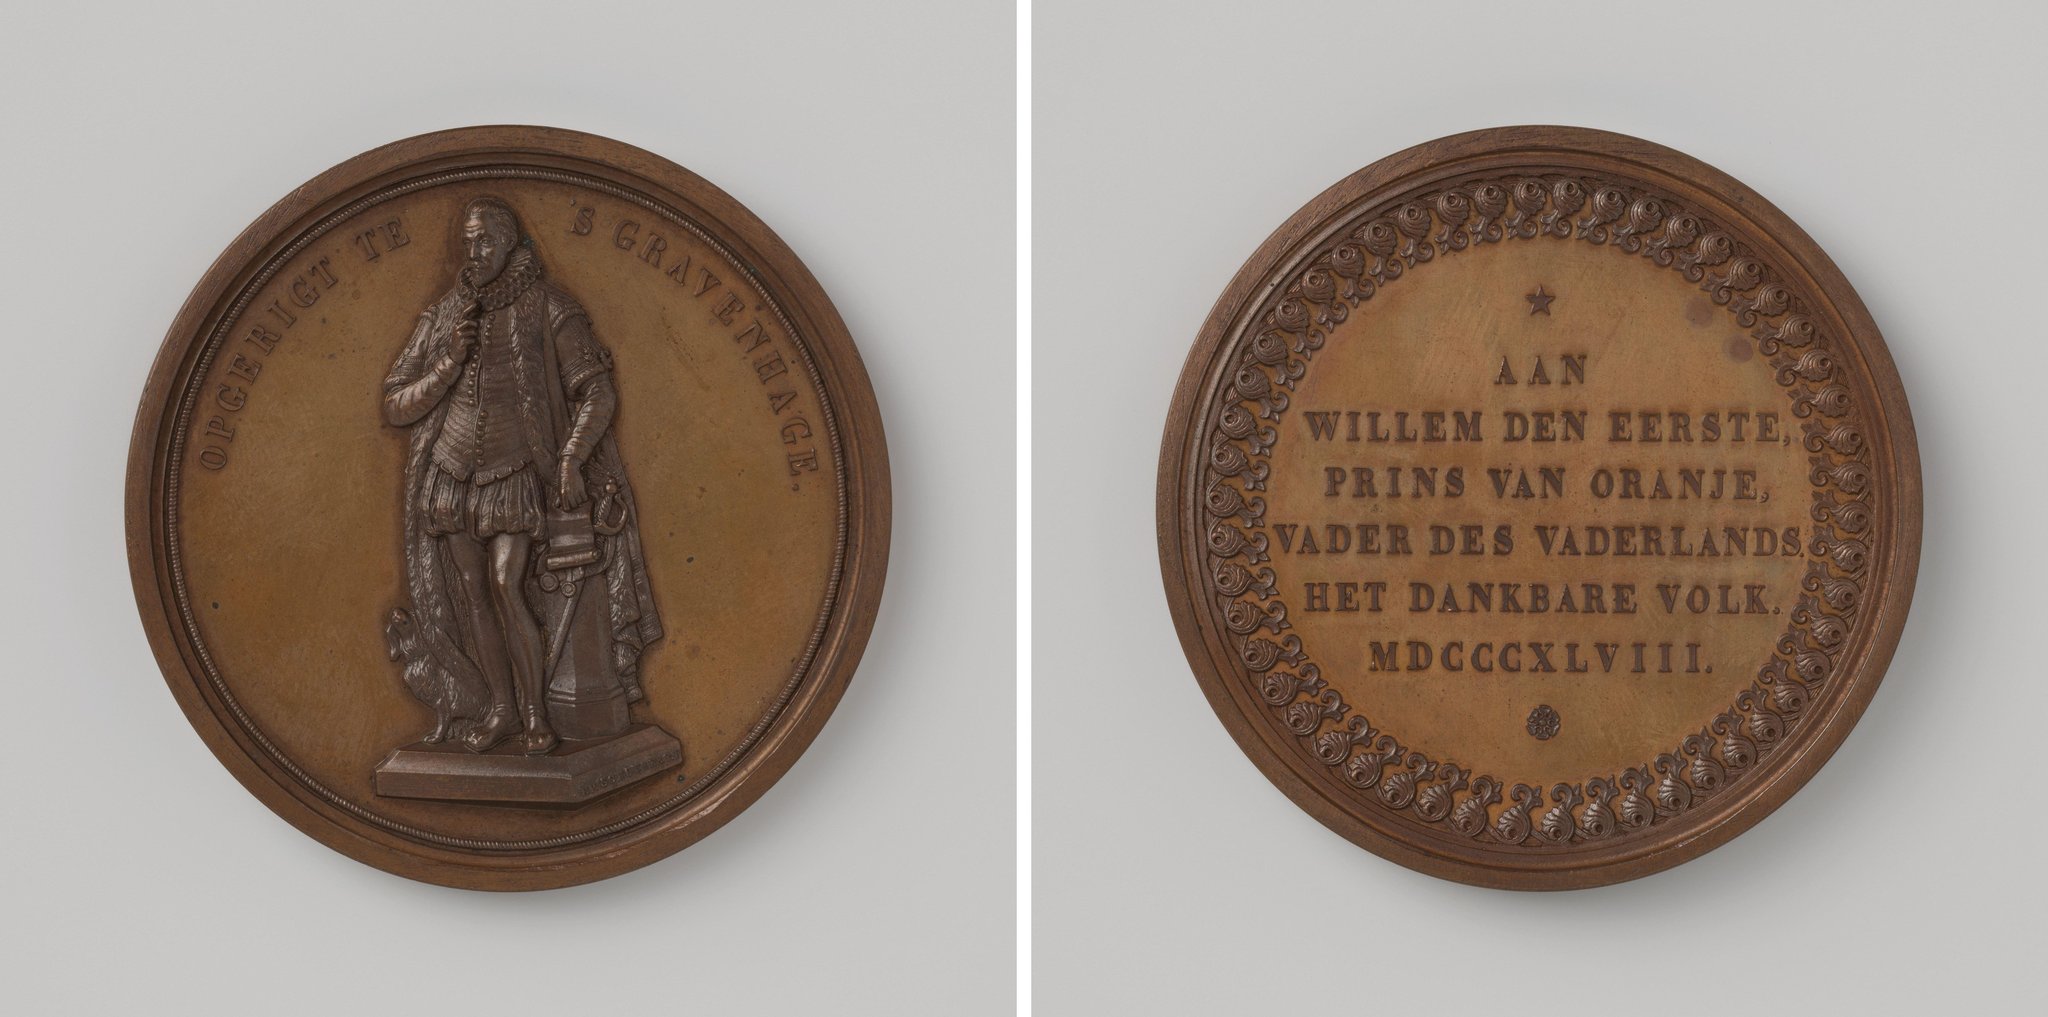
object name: history medal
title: Oprichting van het standbeeld van Willem van Oranje te Den Haag 1848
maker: johannis petrus schouberg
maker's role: die cutter, draughtsman, print maker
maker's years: 1798-1864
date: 1848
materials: bronze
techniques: striking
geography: utrecht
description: Bronzen penning, op de voorzijde het standbeeld half van rechts met bovenaan omschrift, op de keerzijde zes regels tekst binnen een ornamentale rand.